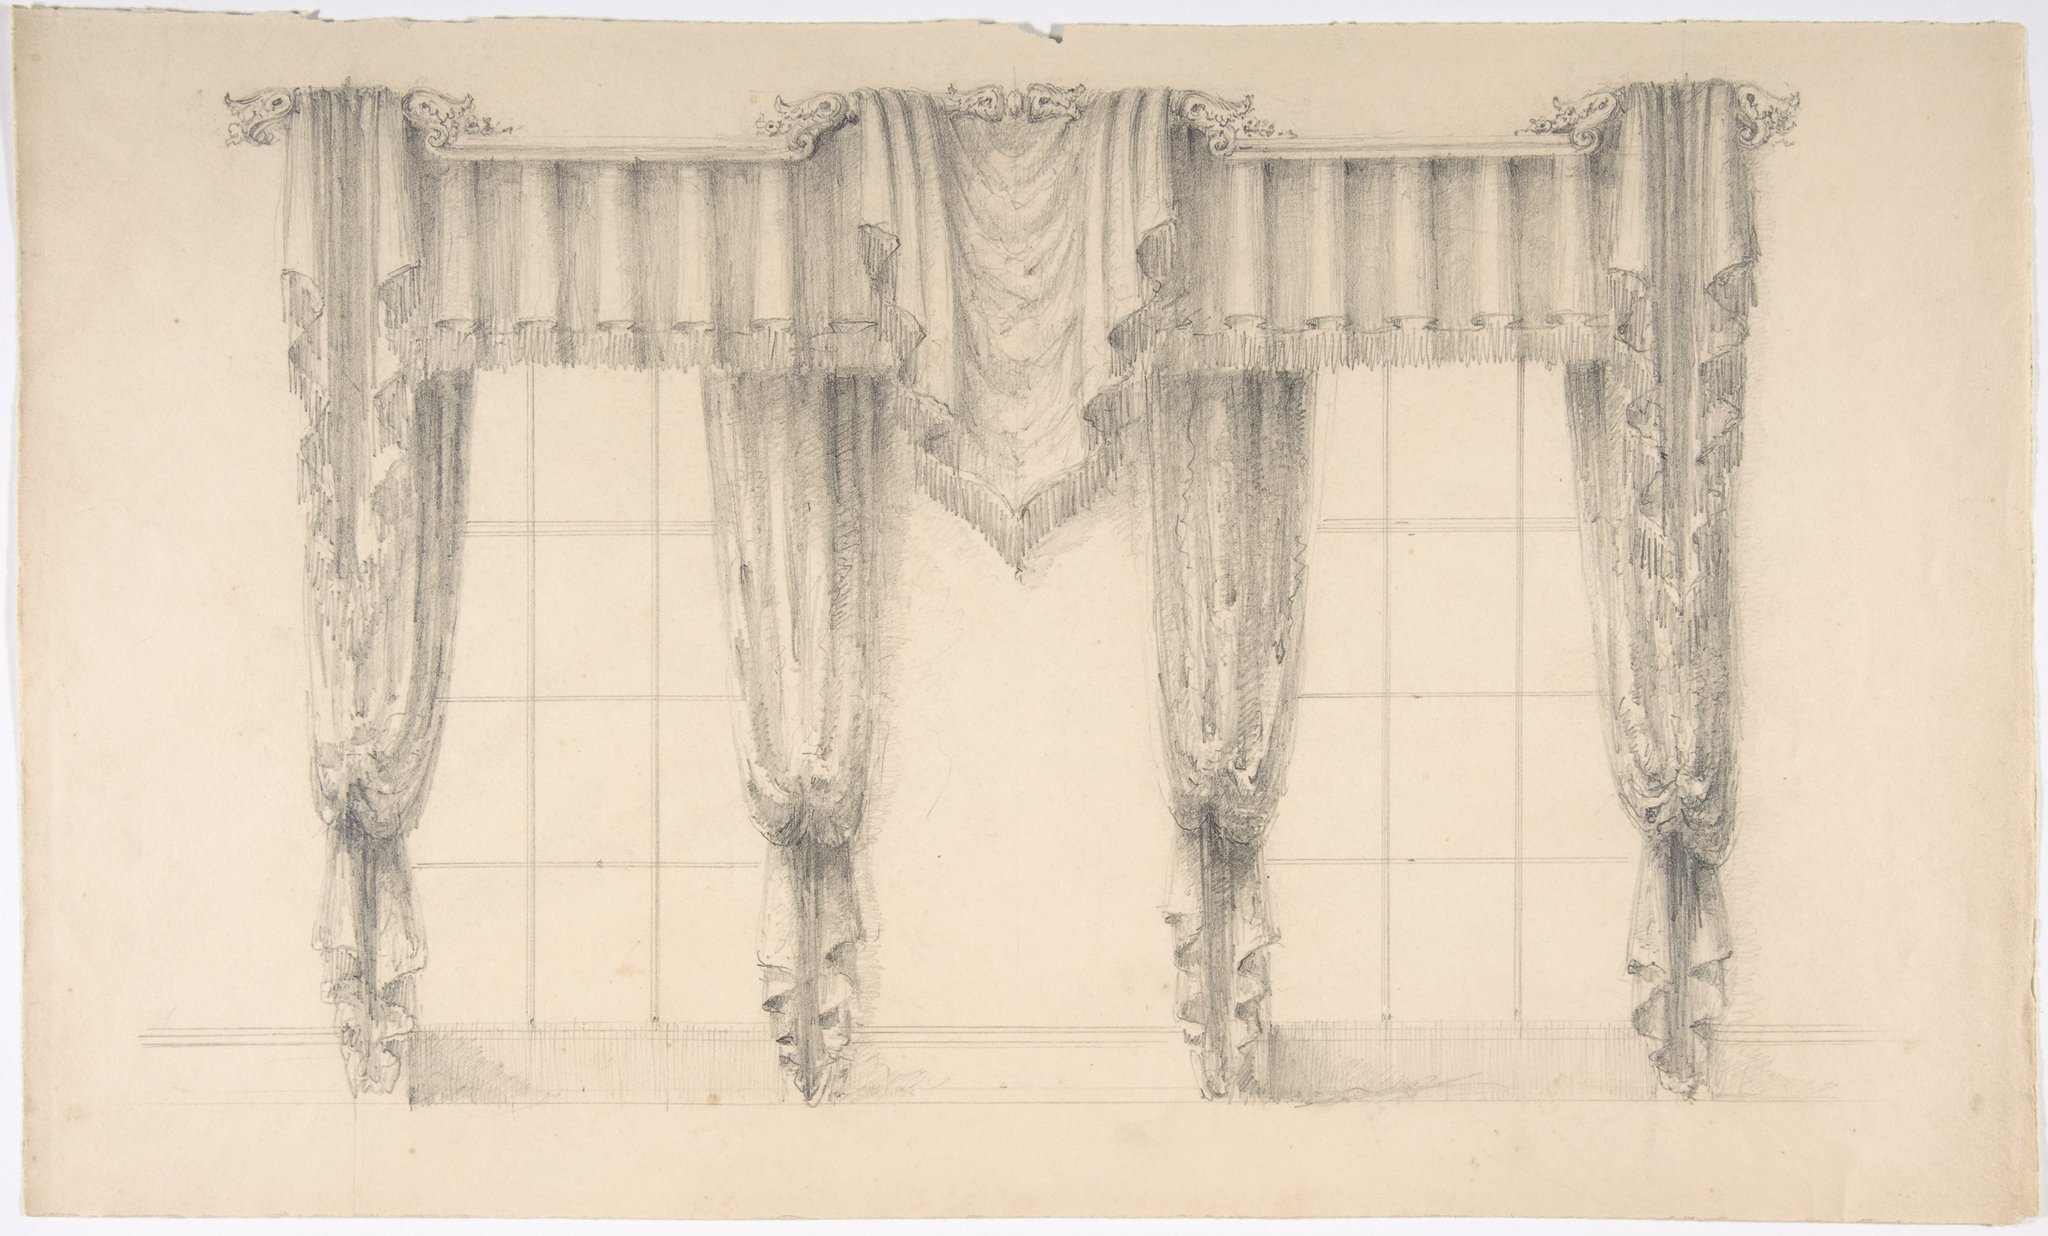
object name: drawing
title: Design for Fringed Curtains Surrounding Two WIndows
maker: anonymous, british, 19th century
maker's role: artist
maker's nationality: british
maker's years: 1800-1900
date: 1801-1833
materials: graphite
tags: curtains